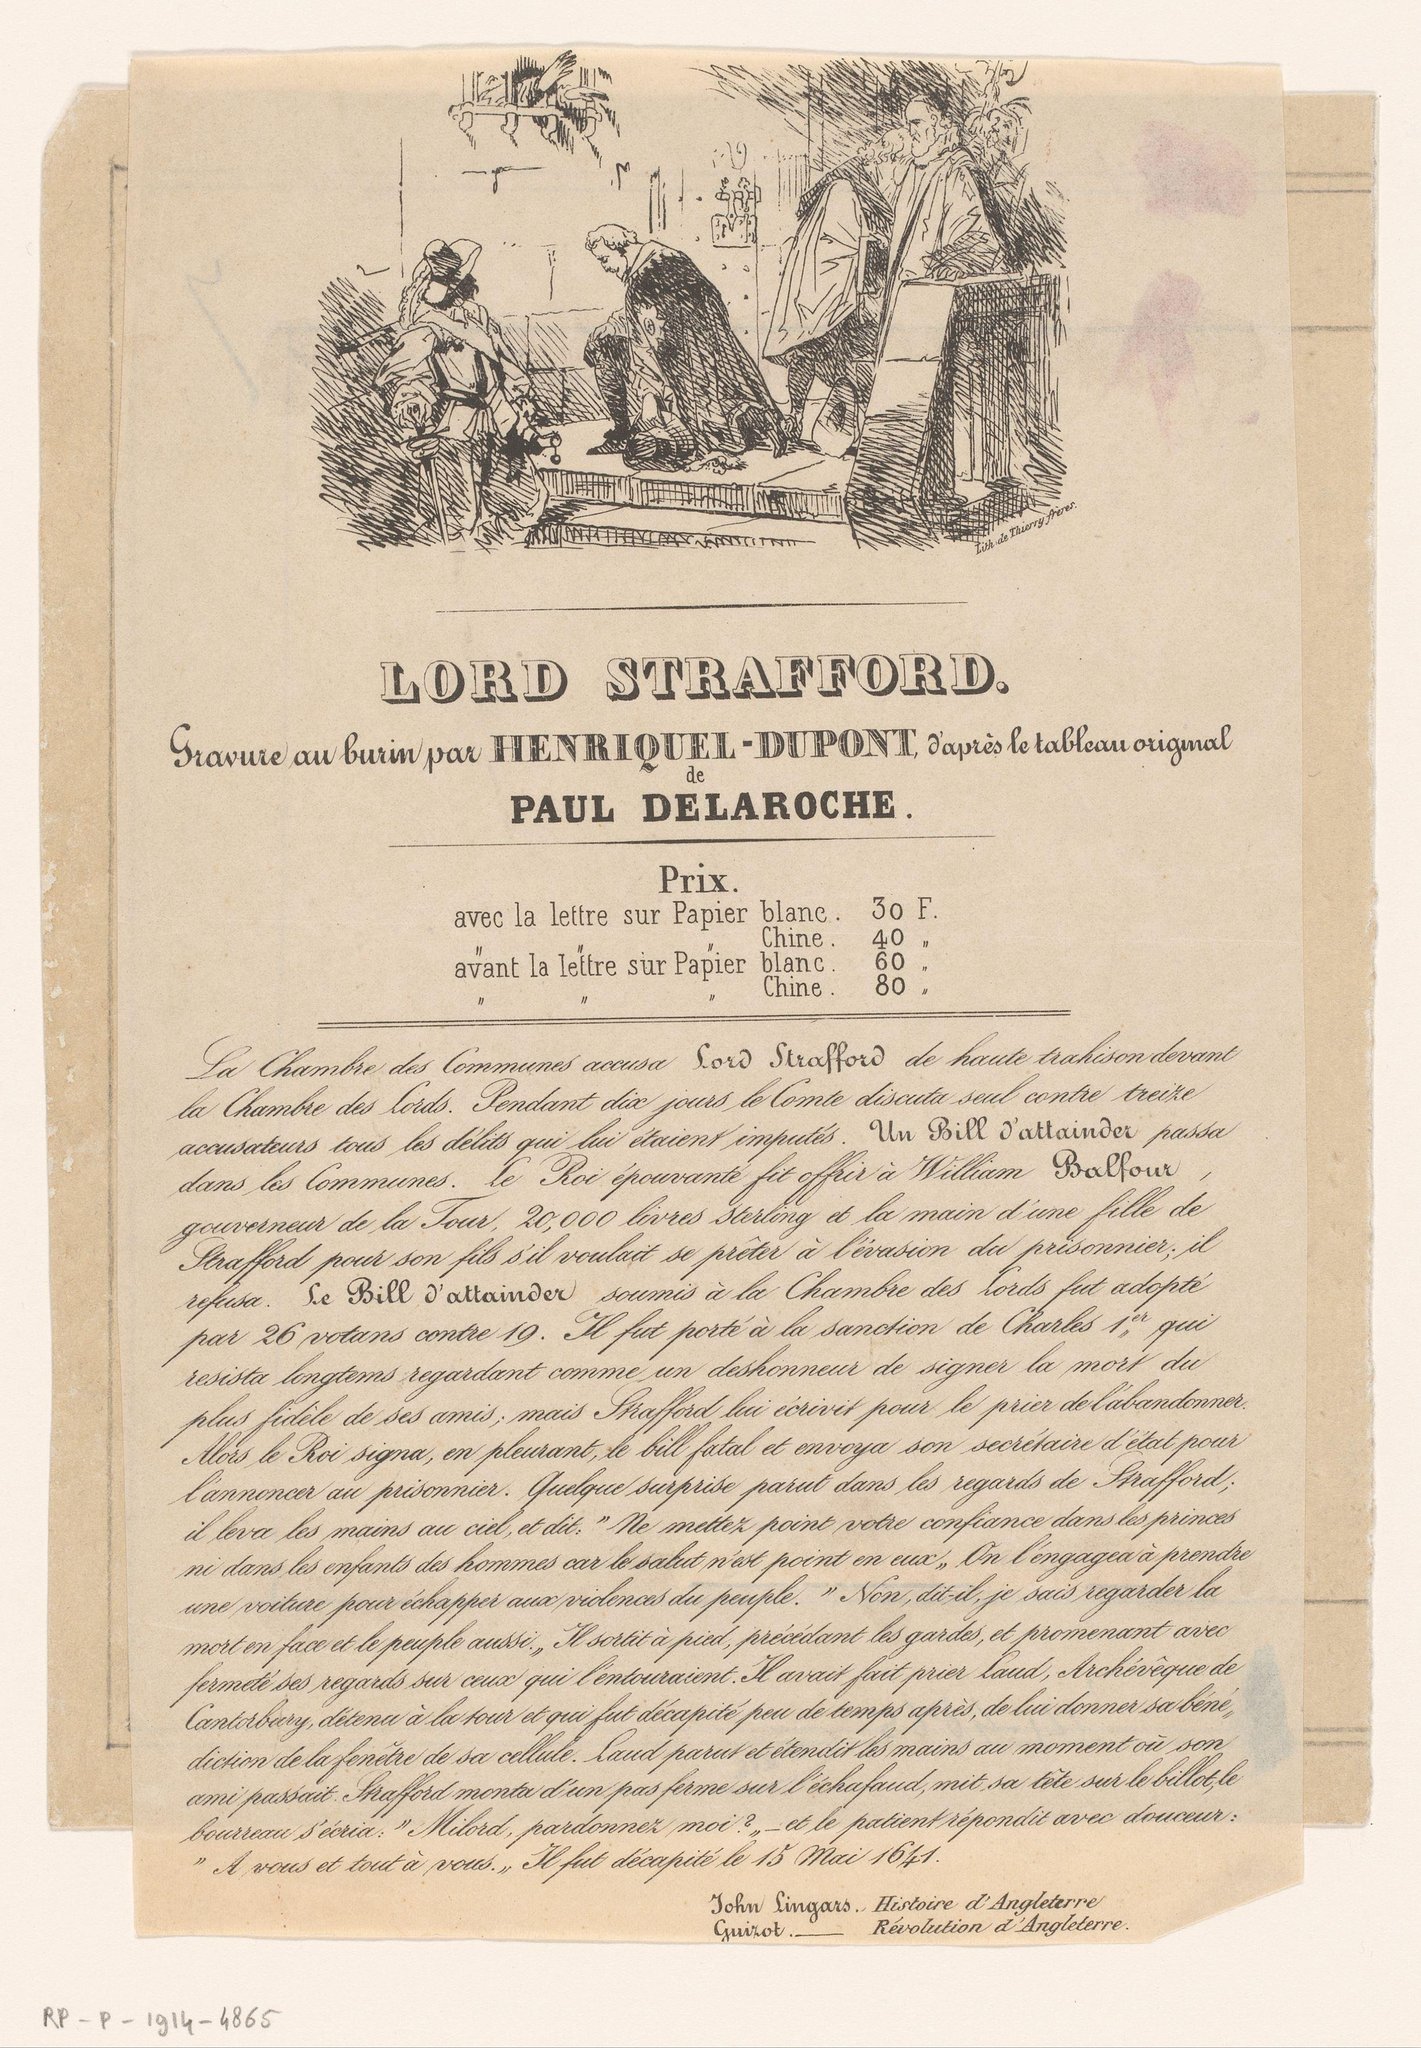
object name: print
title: Prospectus van de verkoop van een prent waarop Thomas Wentworth naar zijn executie wordt geleid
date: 1840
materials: paper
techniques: lithograph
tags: london, politician, prison, jail, last hours before execution, historical persons